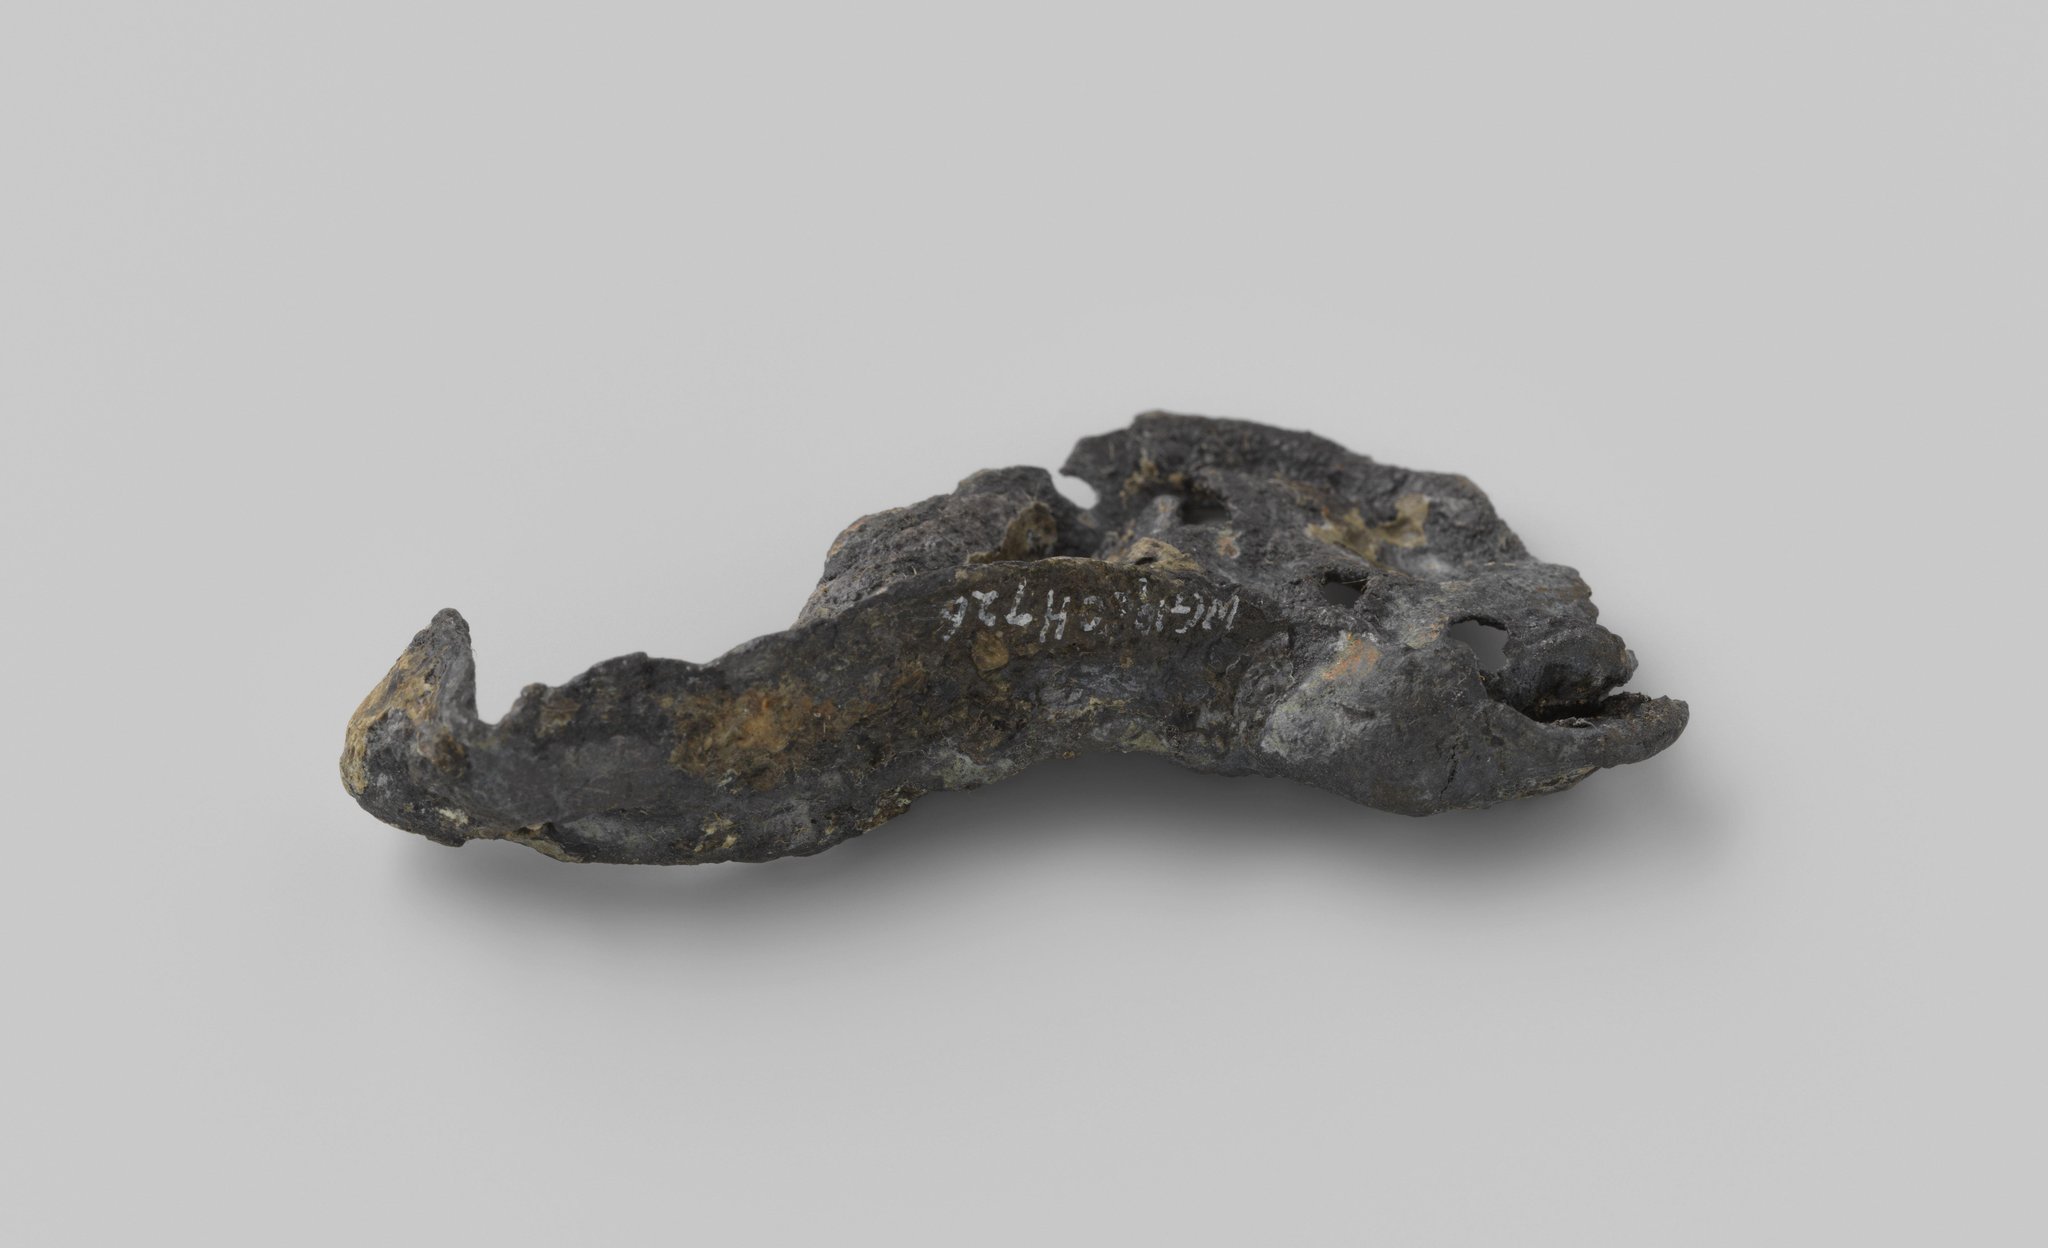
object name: fragment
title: Fragment van tin uit het wrak van de Oost-Indiëvaarder Hollandia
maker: Anonymous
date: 1700-1743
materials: tin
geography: netherlands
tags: verenigde oostindische compagnie, hollandia (schip), annet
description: Varied parts or fragments, sheet metal fragments: worked; fragm, squashed, eroded, with 3 circular holes.